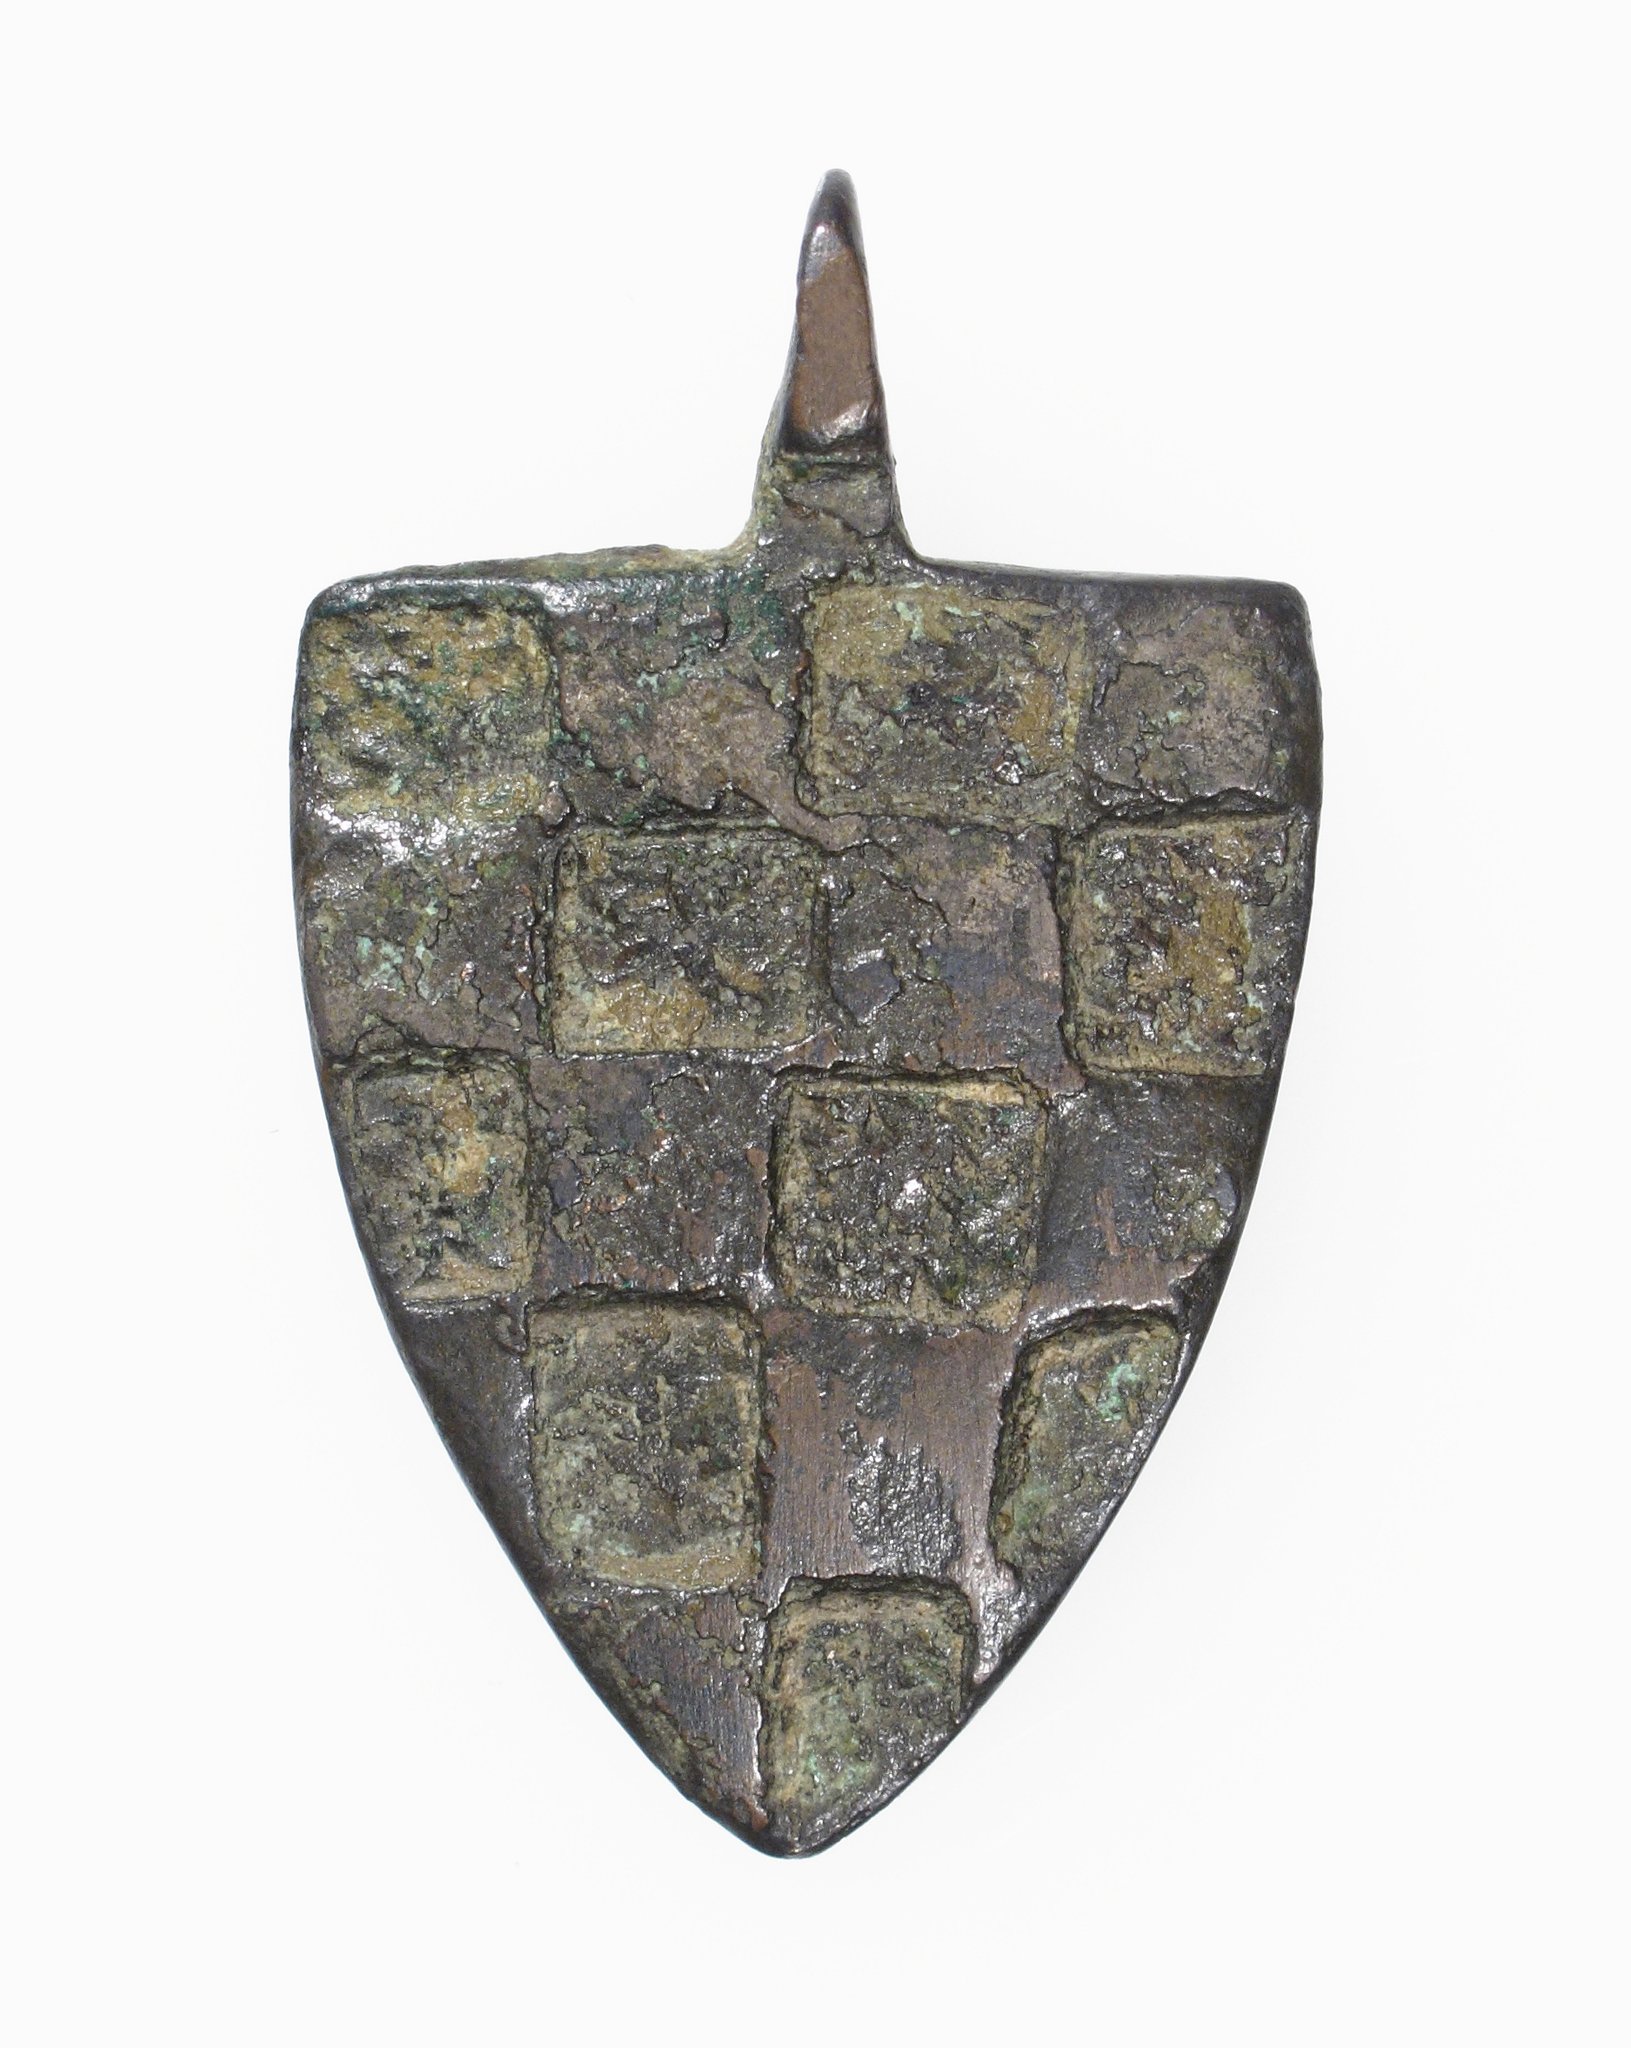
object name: horse trapping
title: Horse Trappings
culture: spanish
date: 1301-1400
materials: copper alloy, enamel, gilt copper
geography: spain